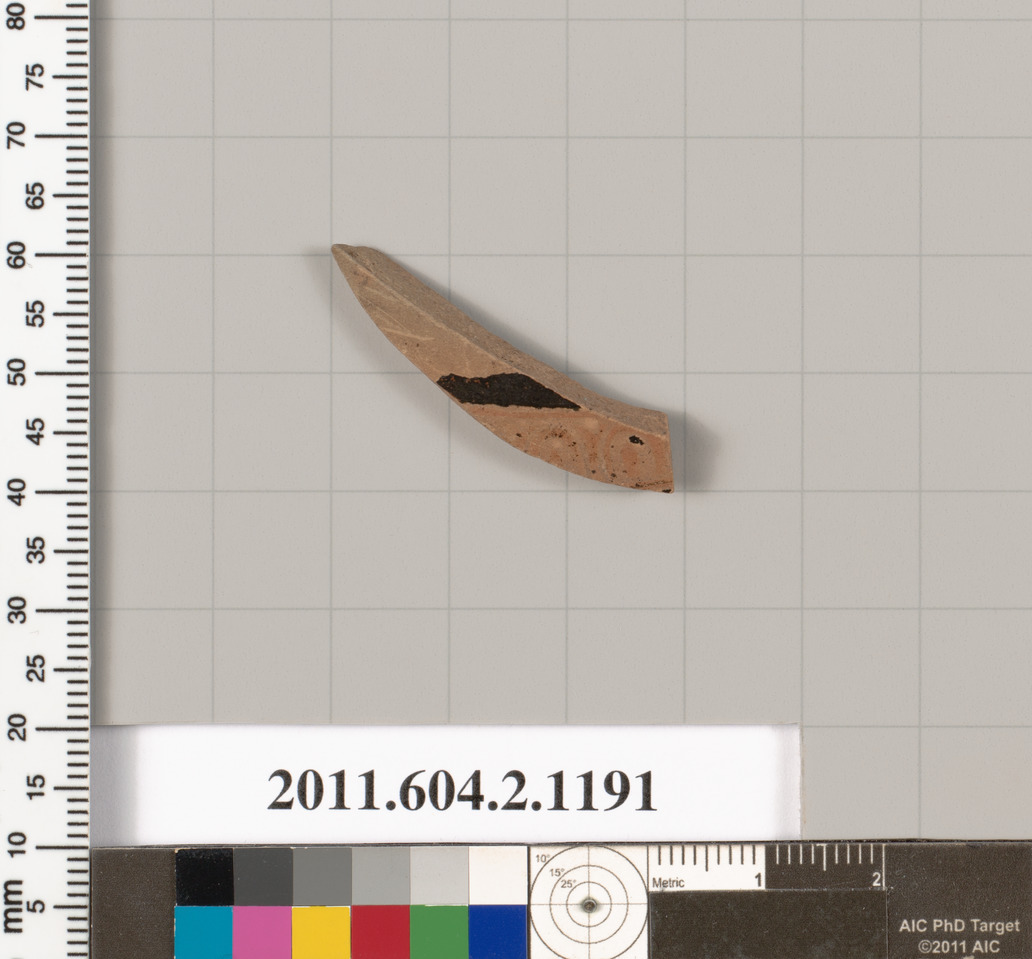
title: Terracotta fragment from a closed shape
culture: greek, attic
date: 450-401 BCE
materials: terracotta